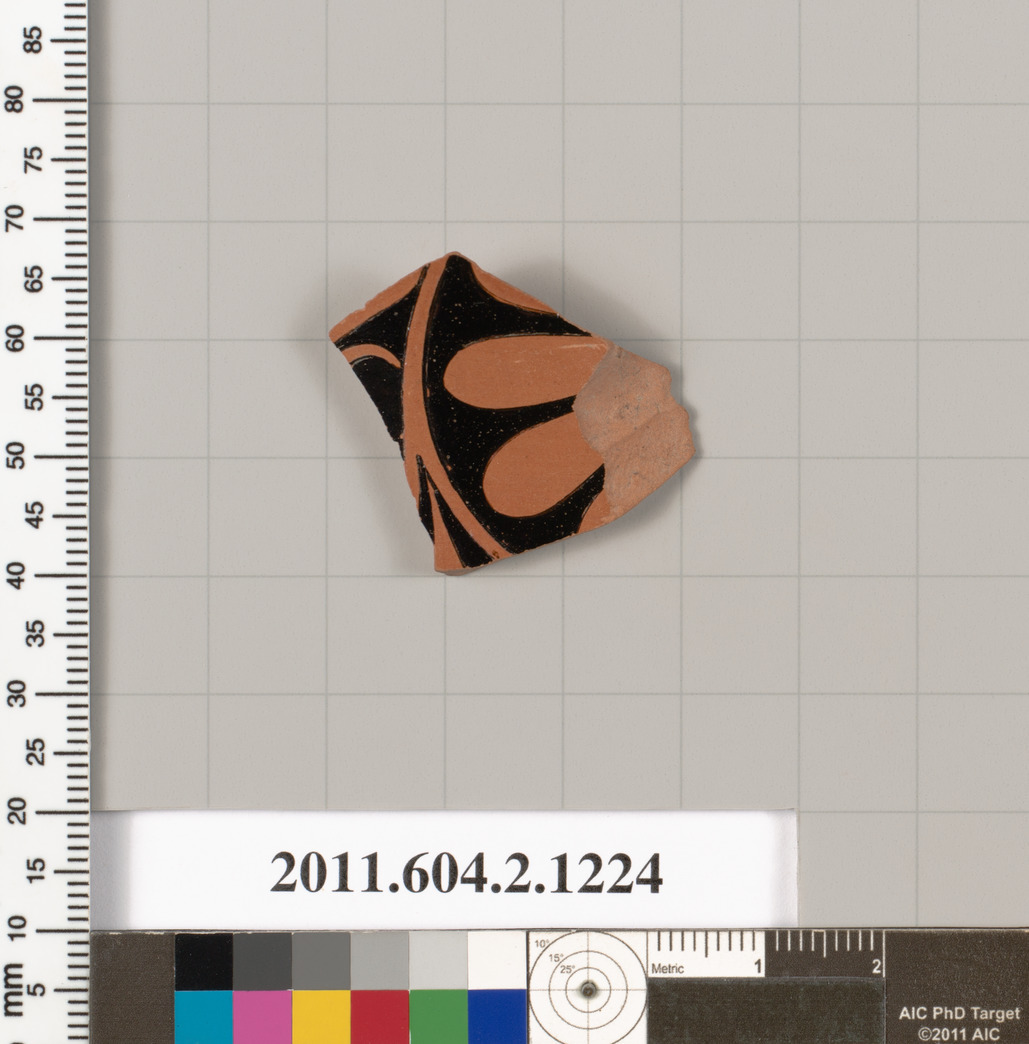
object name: kantharos fragment, head vase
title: Terracotta fragment from a kantharos: head vase?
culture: greek, attic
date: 534-468 BCE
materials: terracotta